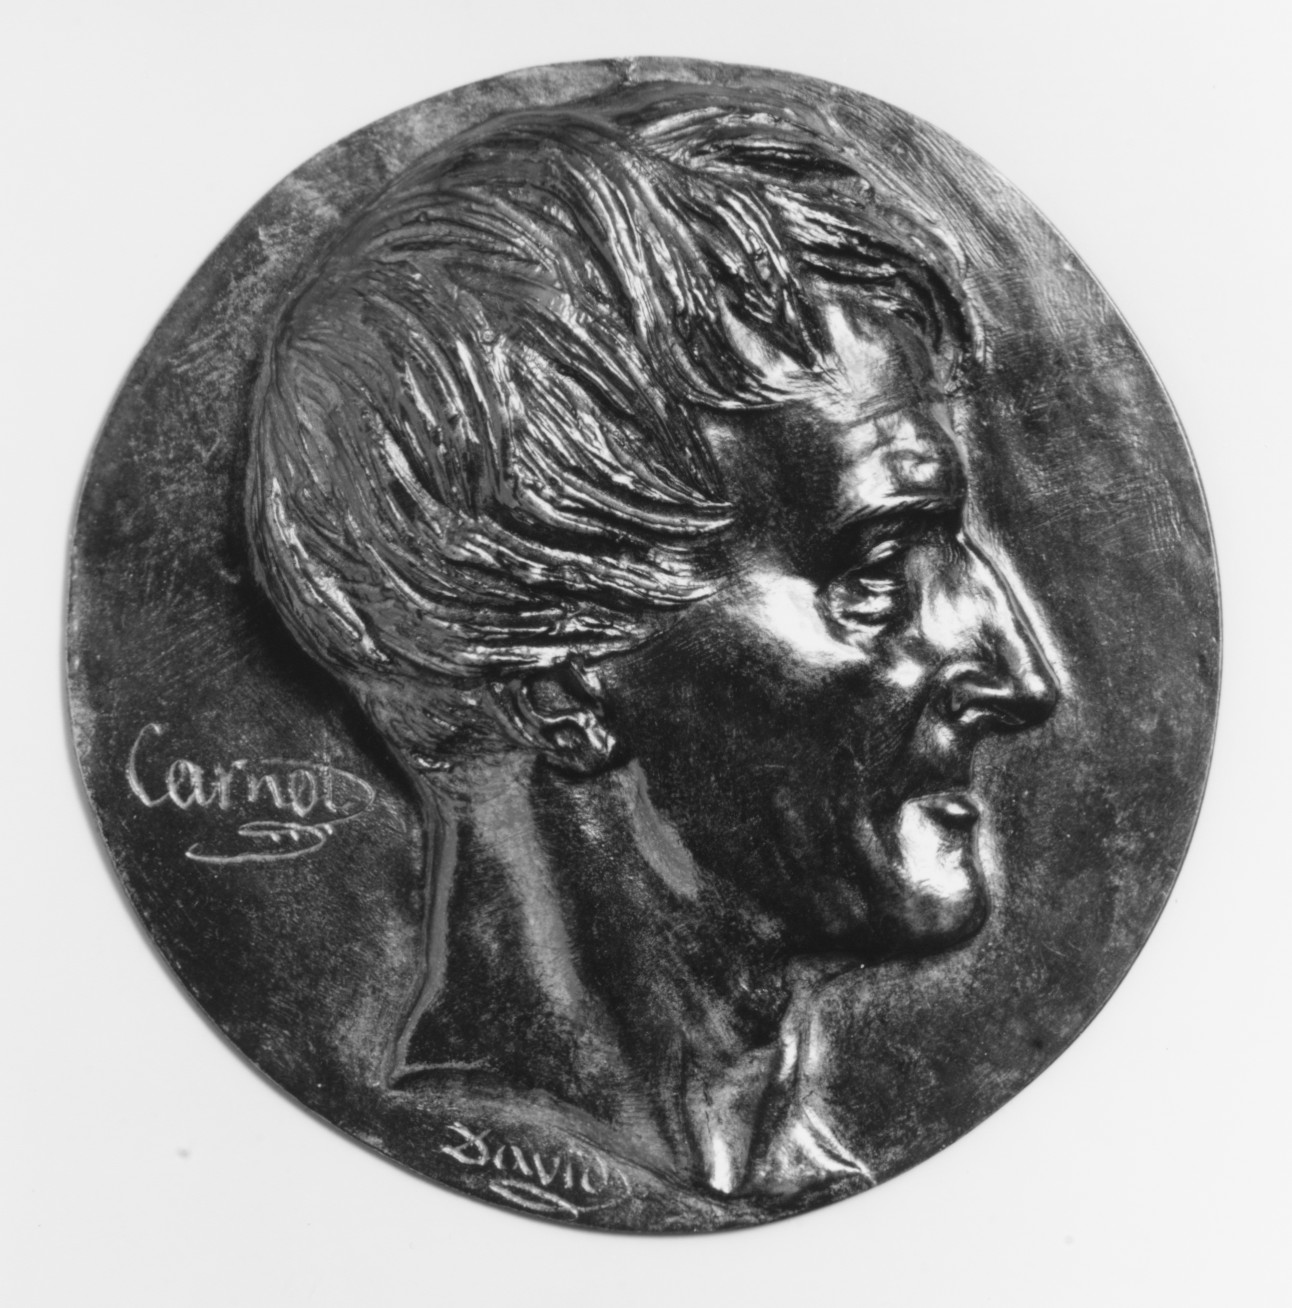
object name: medallion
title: Lazare Carnot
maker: pierre jean david d'angers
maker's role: artist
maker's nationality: french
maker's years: 1788-1856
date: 1801-1900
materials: bronze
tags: men,profiles